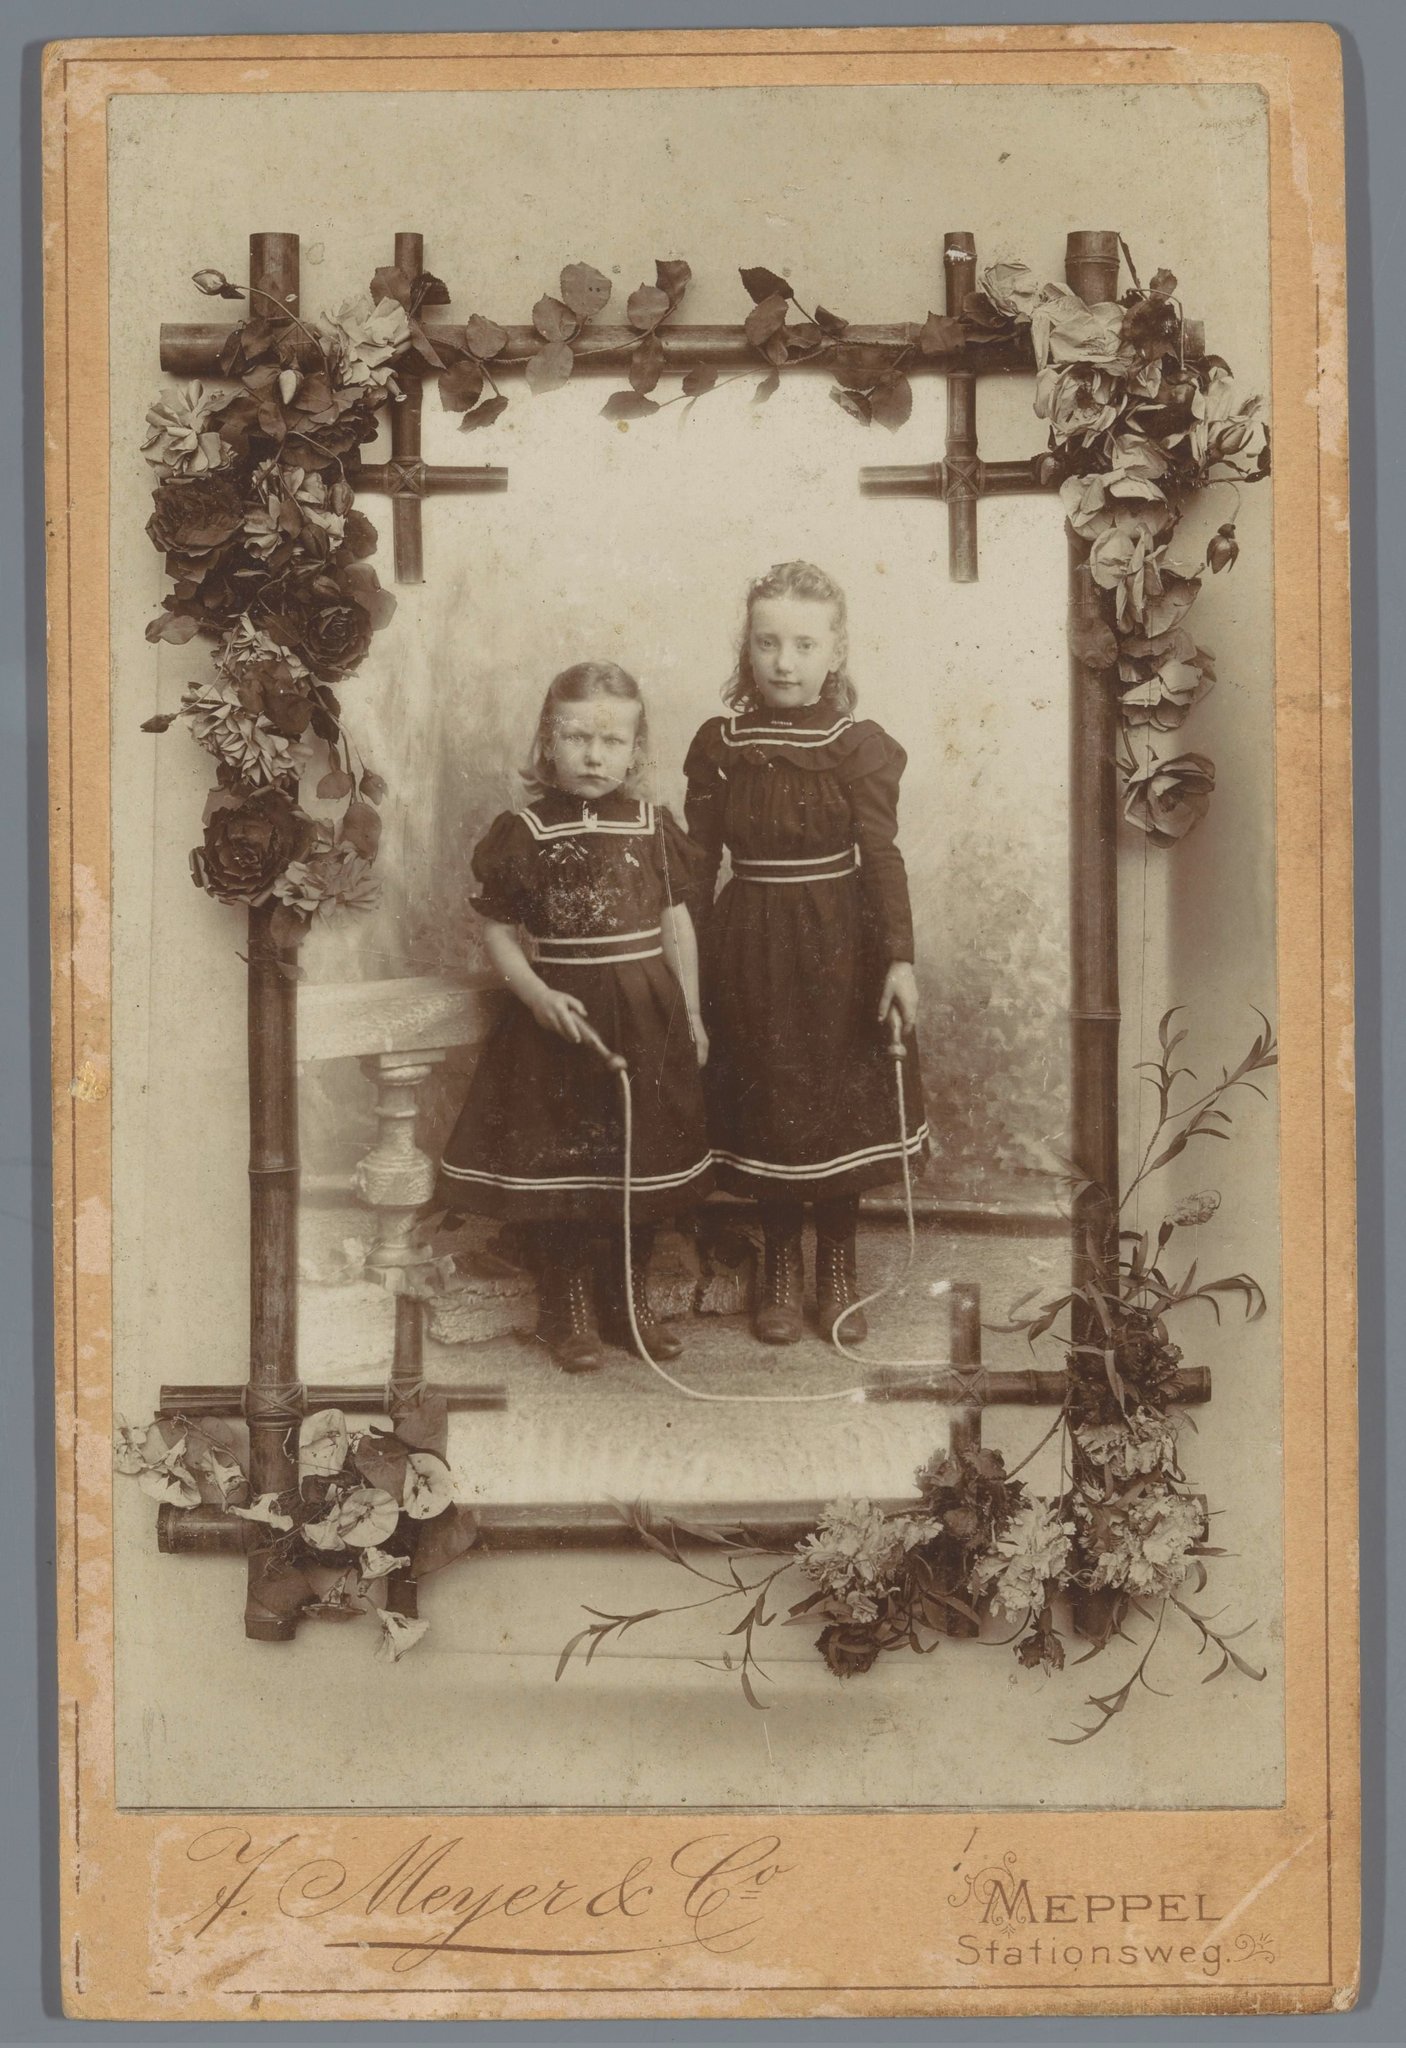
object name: cabinet photograph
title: Portret van twee meisjes met een springtouw in een omlijsting met bloemen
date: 1890-1905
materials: cardboard, photographic support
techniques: gelatin silver print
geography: meppel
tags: flowers, girl (child between toddler and youth), jumping-rope games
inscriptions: inscription: ‘Photographisch Atelier van J. Meyer & Co. Meppel Stationsweg Specialiteit in Vergrootingen De plaat blijft voor Nabestelling bewaard.’